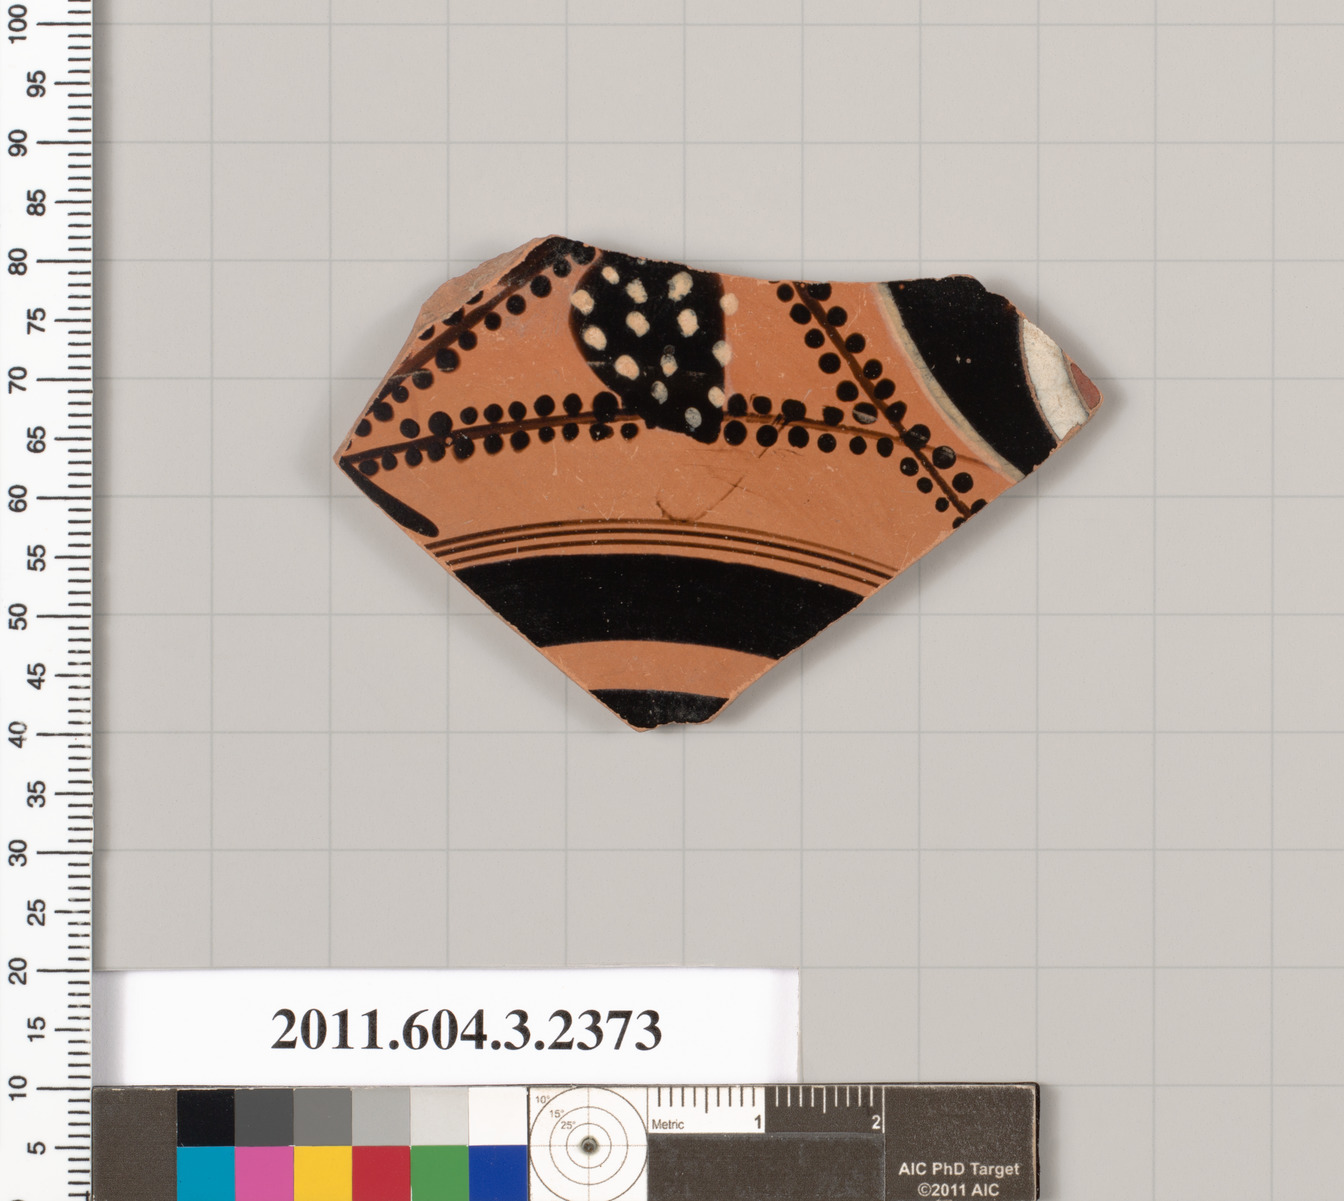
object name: kylix fragment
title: Terracotta fragment of a kylix: eye-cup (drinking cup)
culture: greek, attic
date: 540-520 BCE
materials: terracotta